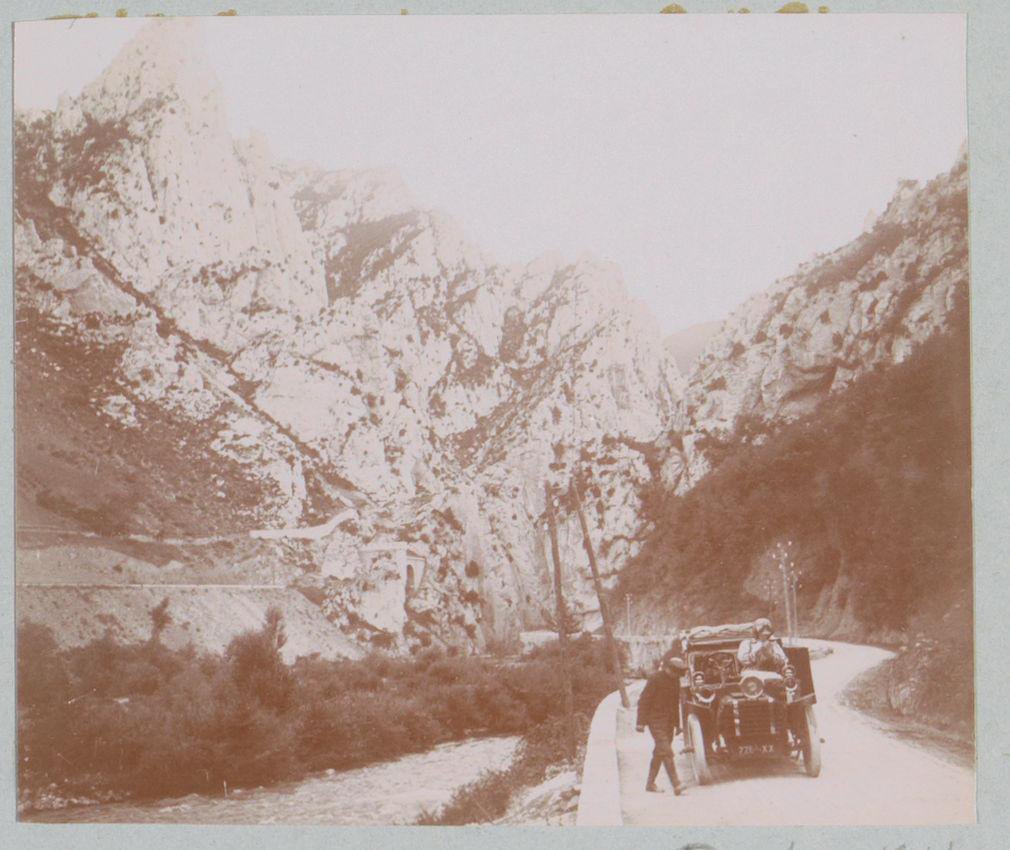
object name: photograph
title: Man en een vrouw bij een auto in een bergkloof, vermoedelijk in de Pyreneeën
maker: Anonymous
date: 1905-1910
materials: paper, photographic support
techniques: gelatin silver print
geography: pyrenees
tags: ravine, chasm, abyss, canyon, road, path, brook, mountains (+ landscape with figures, staffage), automobile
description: Onderdeel van Fotoalbum van een Franse amateurfotograaf met bezienswaardigheden in Frankrijk, Zwitserland en Italië.